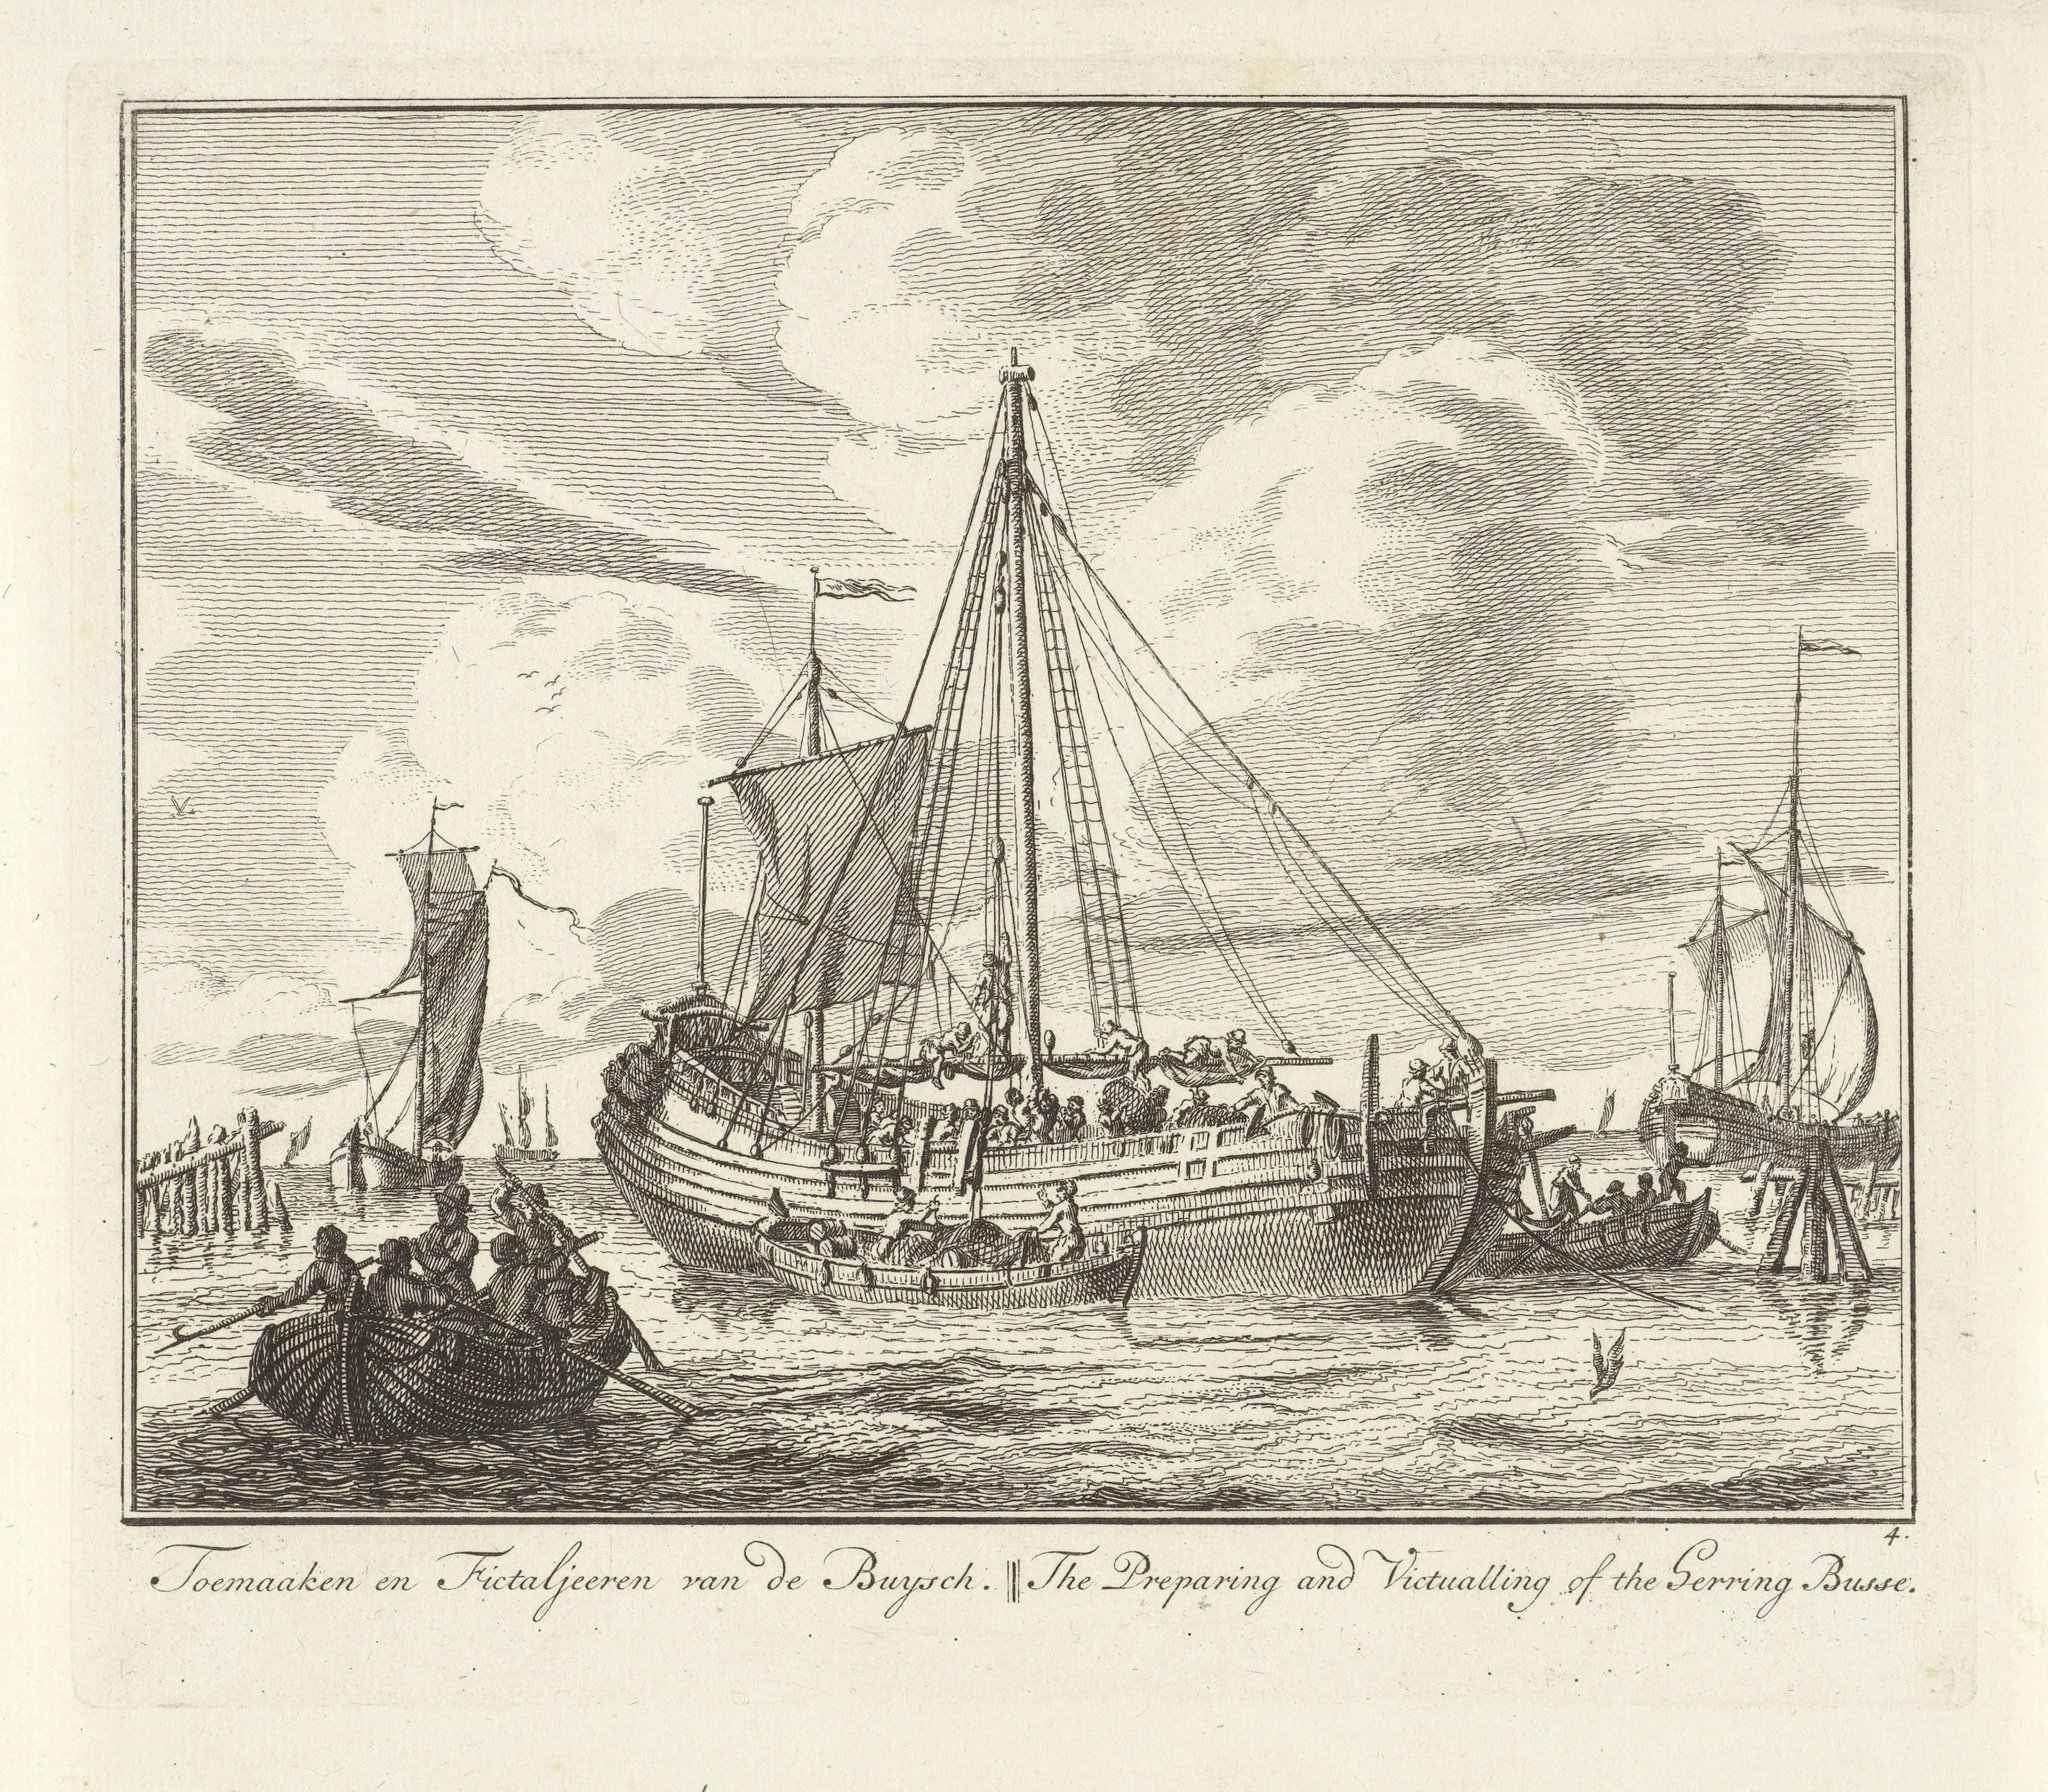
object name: print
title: Uitrusten en bevoorraden van de haringbuis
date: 1728-1761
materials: paper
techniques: etching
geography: amsterdam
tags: bony fishes: herring, sea and coastal fishery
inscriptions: collector's mark: Lugt 2228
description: Muller beschrijft onder FMH 3013C een ander volledig exemplaar van de serie bestaande uit 32 platen. In dit album zijn slechts 17 prenten uit de serie aanwezig (nrs 1-17).